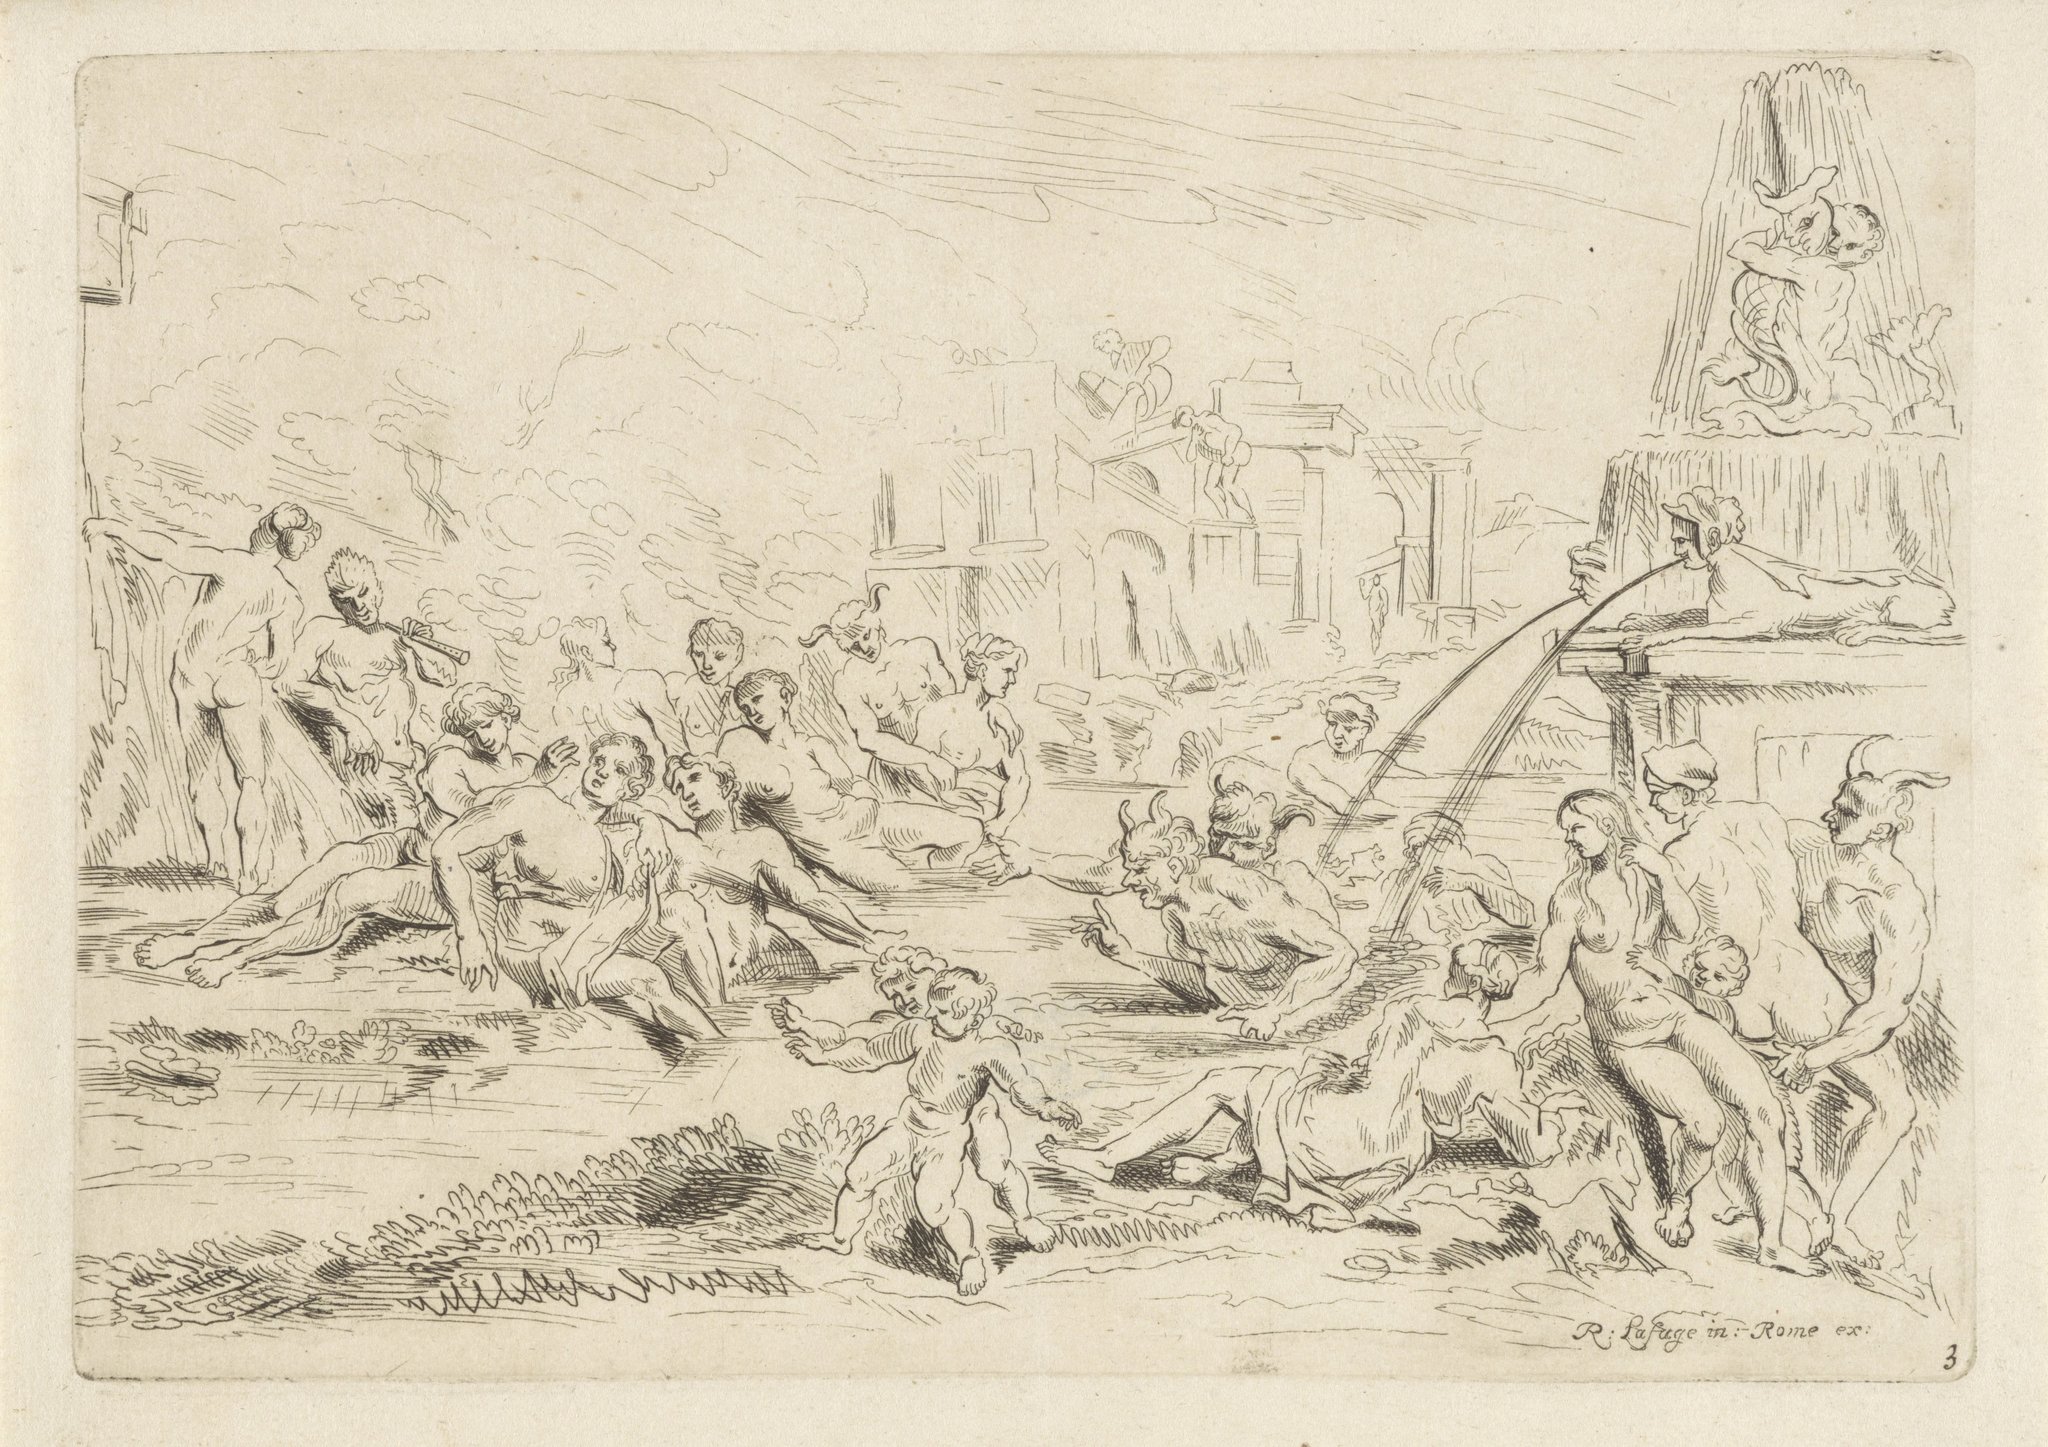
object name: print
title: Bacchanalen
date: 1668-1707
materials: paper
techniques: etching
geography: rome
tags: nymphs (in general); 'ninfe in commune' (ripa), satyr(s) (in general), taking a bath - aa - in the open air, ornamental fountain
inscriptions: collector's mark: Lugt 2228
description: Bij een fontein baden nimfen en saters samen met enkele kinderen.